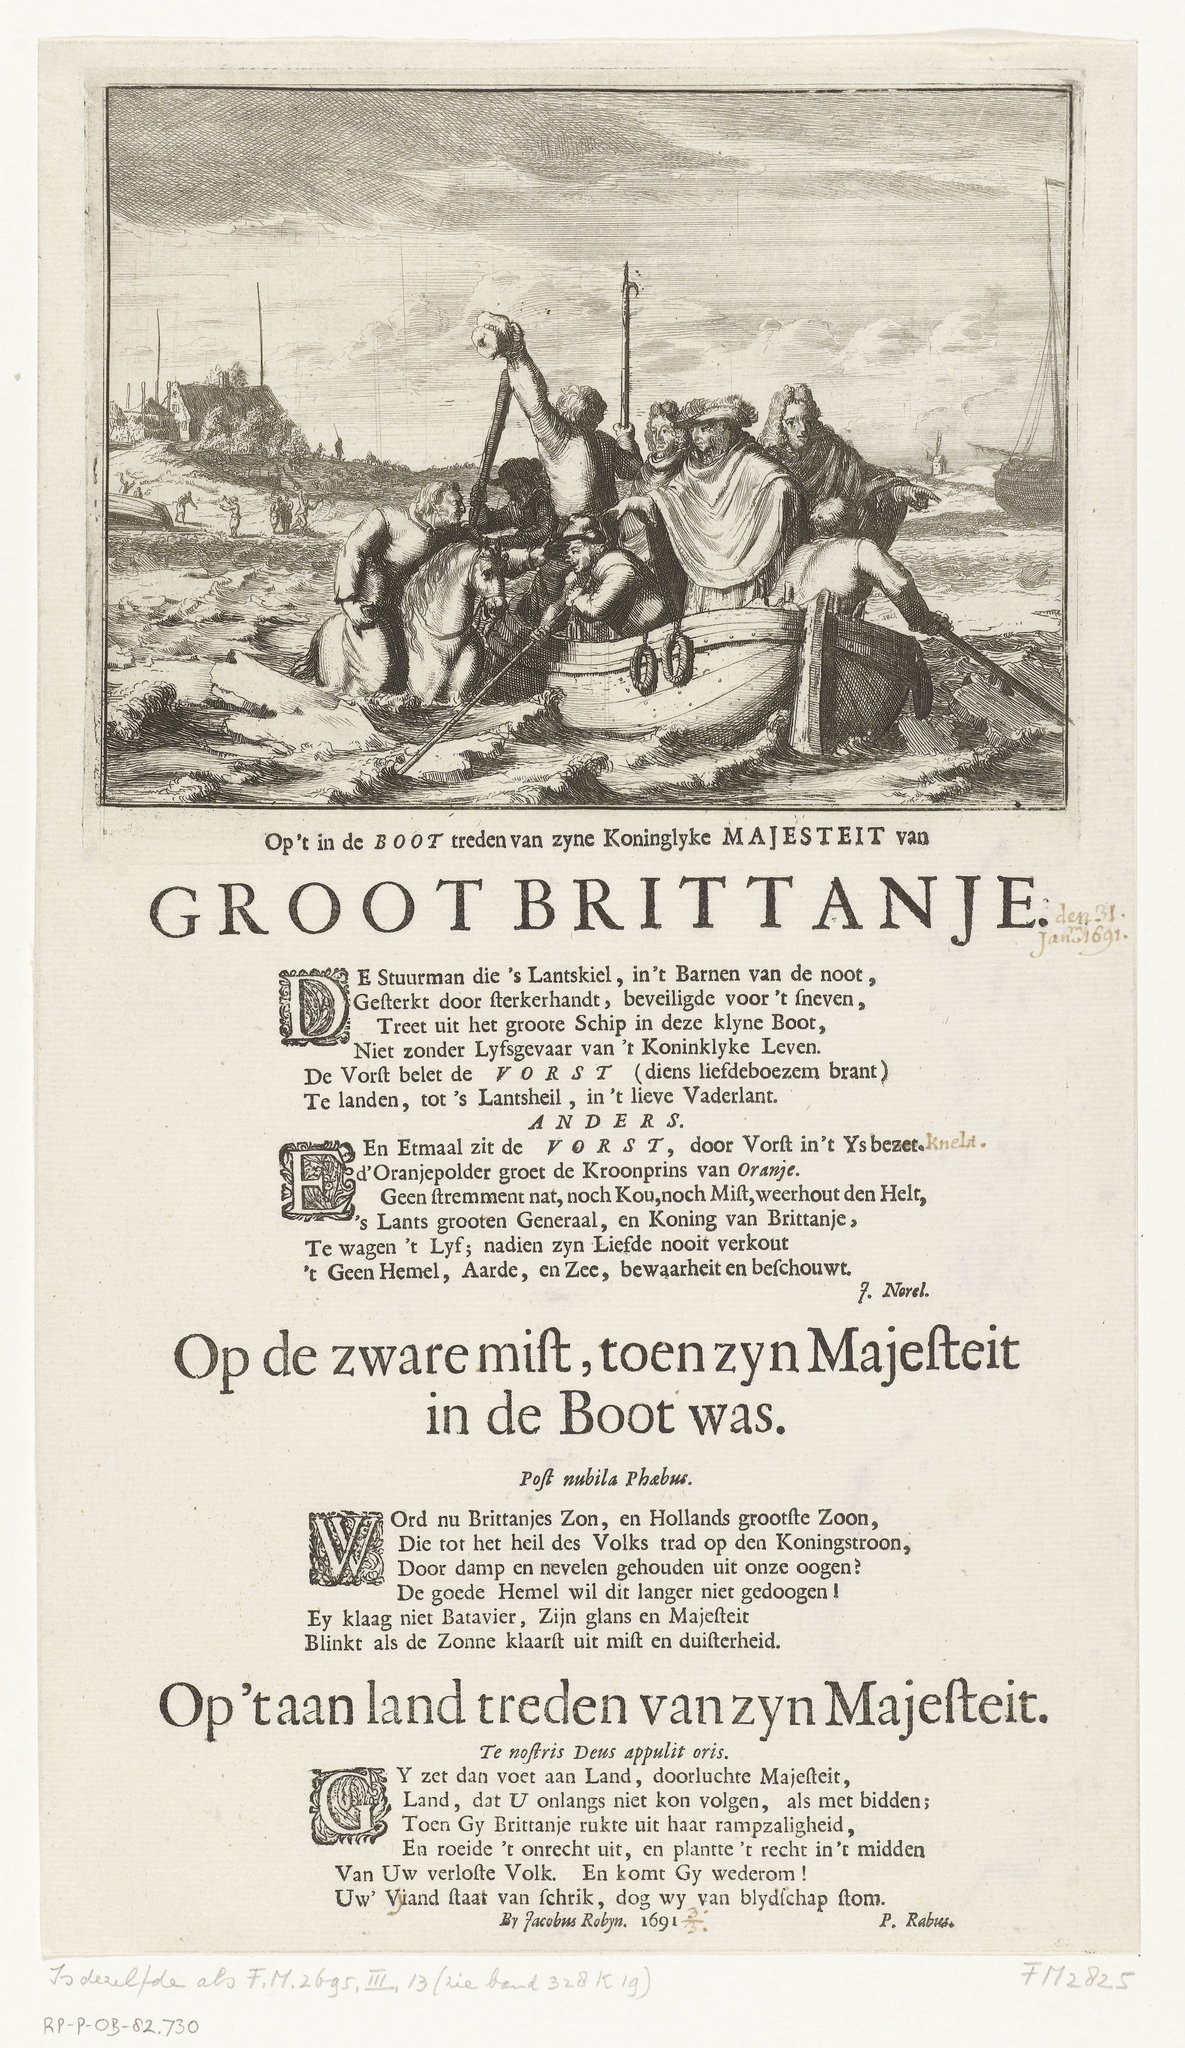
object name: print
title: Aankomst van koning Willem III bij Oranjepolder, 1691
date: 1691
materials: paper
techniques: etching, letterpress printing, writing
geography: amsterdam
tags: the hague, william iii (prince of orange and king of england, scotland, and ireland), arrival and return ~ travelling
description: De aankomst van koning Willem III bij Oranjepolder in Zuid-Holland, 31 januari 1691. Door ijsvorming heeft de roeiboot met Willem III moeite aan land te komen. Met vier verzen onder de plaat: op het plaatsnemen in de boot (twee keer), op de zware mist en op het aan land treden. Op het blad correcties met pen in bruin.